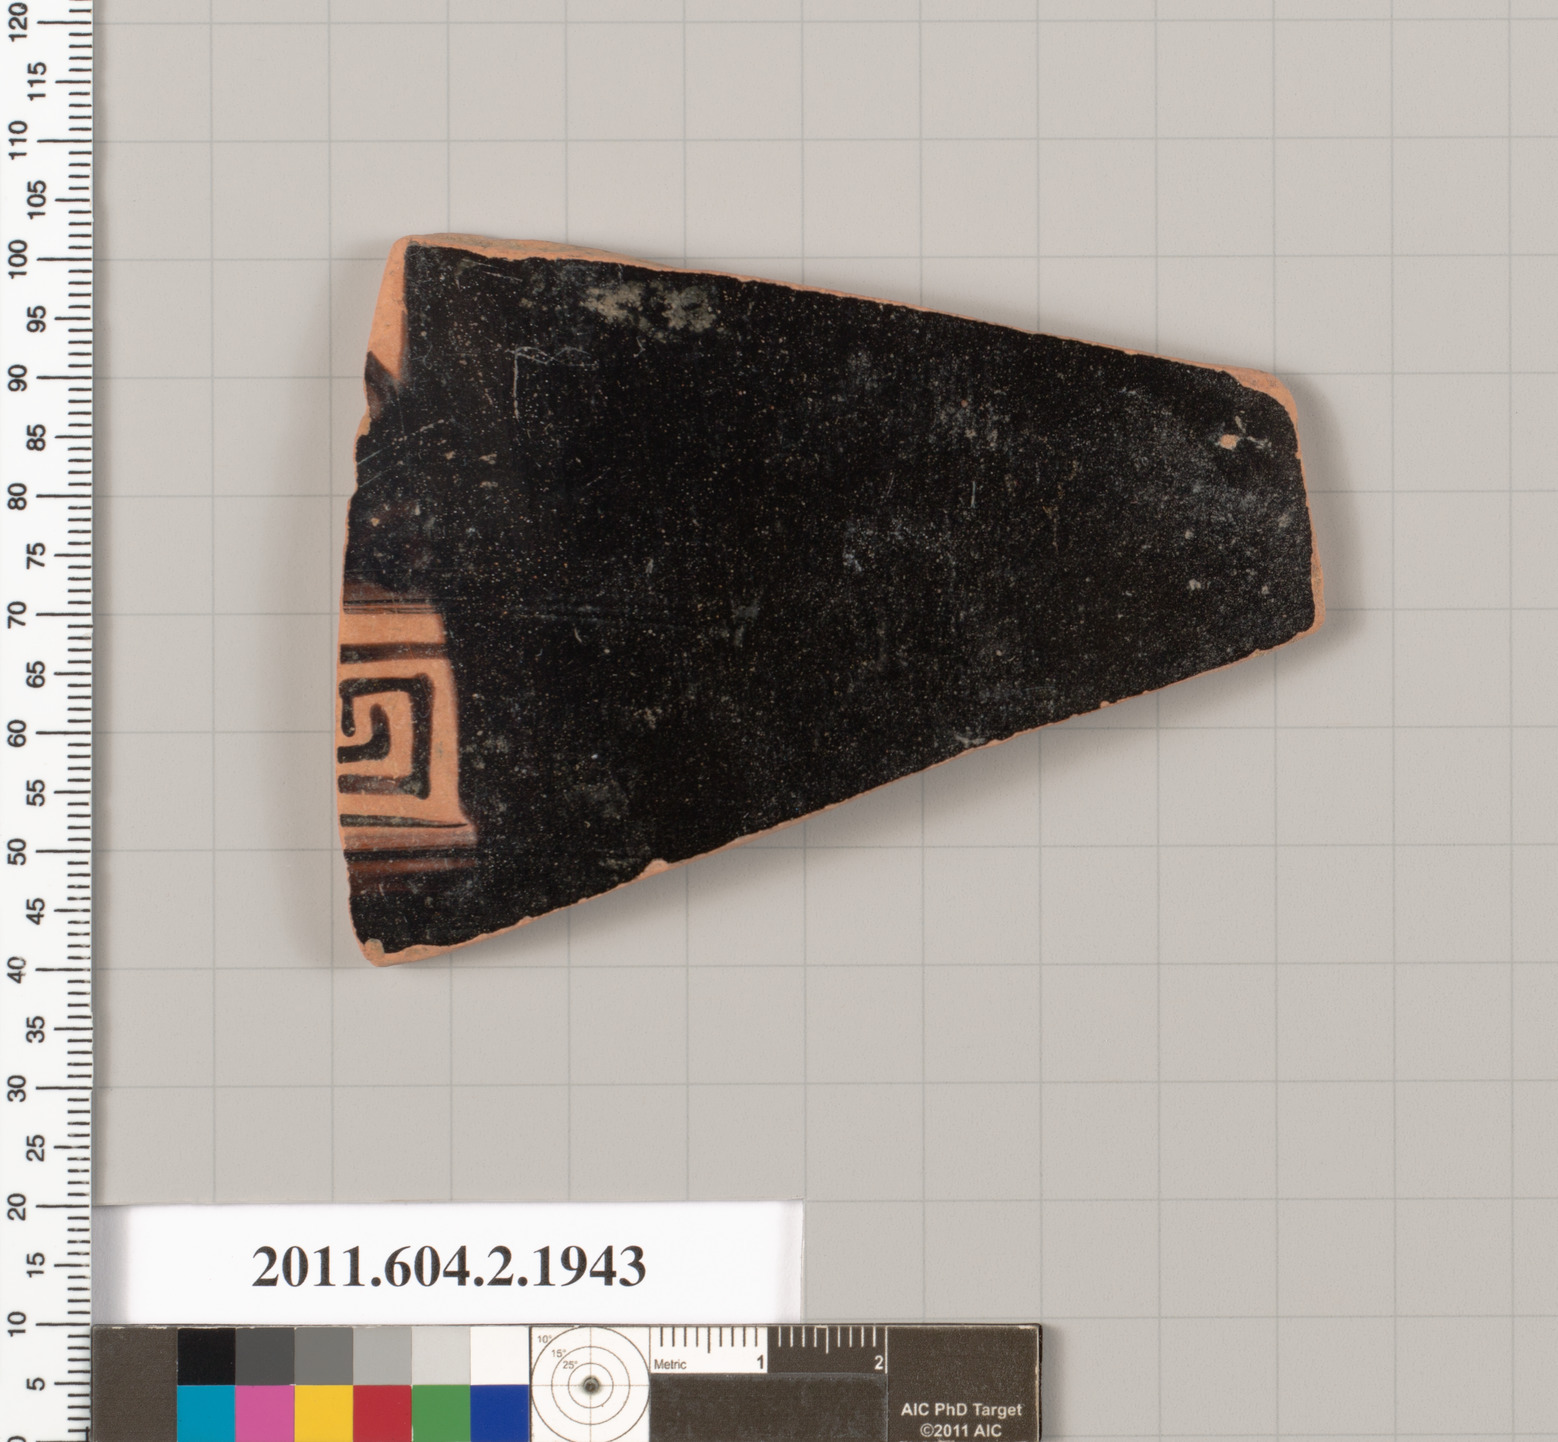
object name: neck amphora fragment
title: Terracotta fragment of a Nolan neck-amphora (jar)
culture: greek, attic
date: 475-460 BCE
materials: terracotta